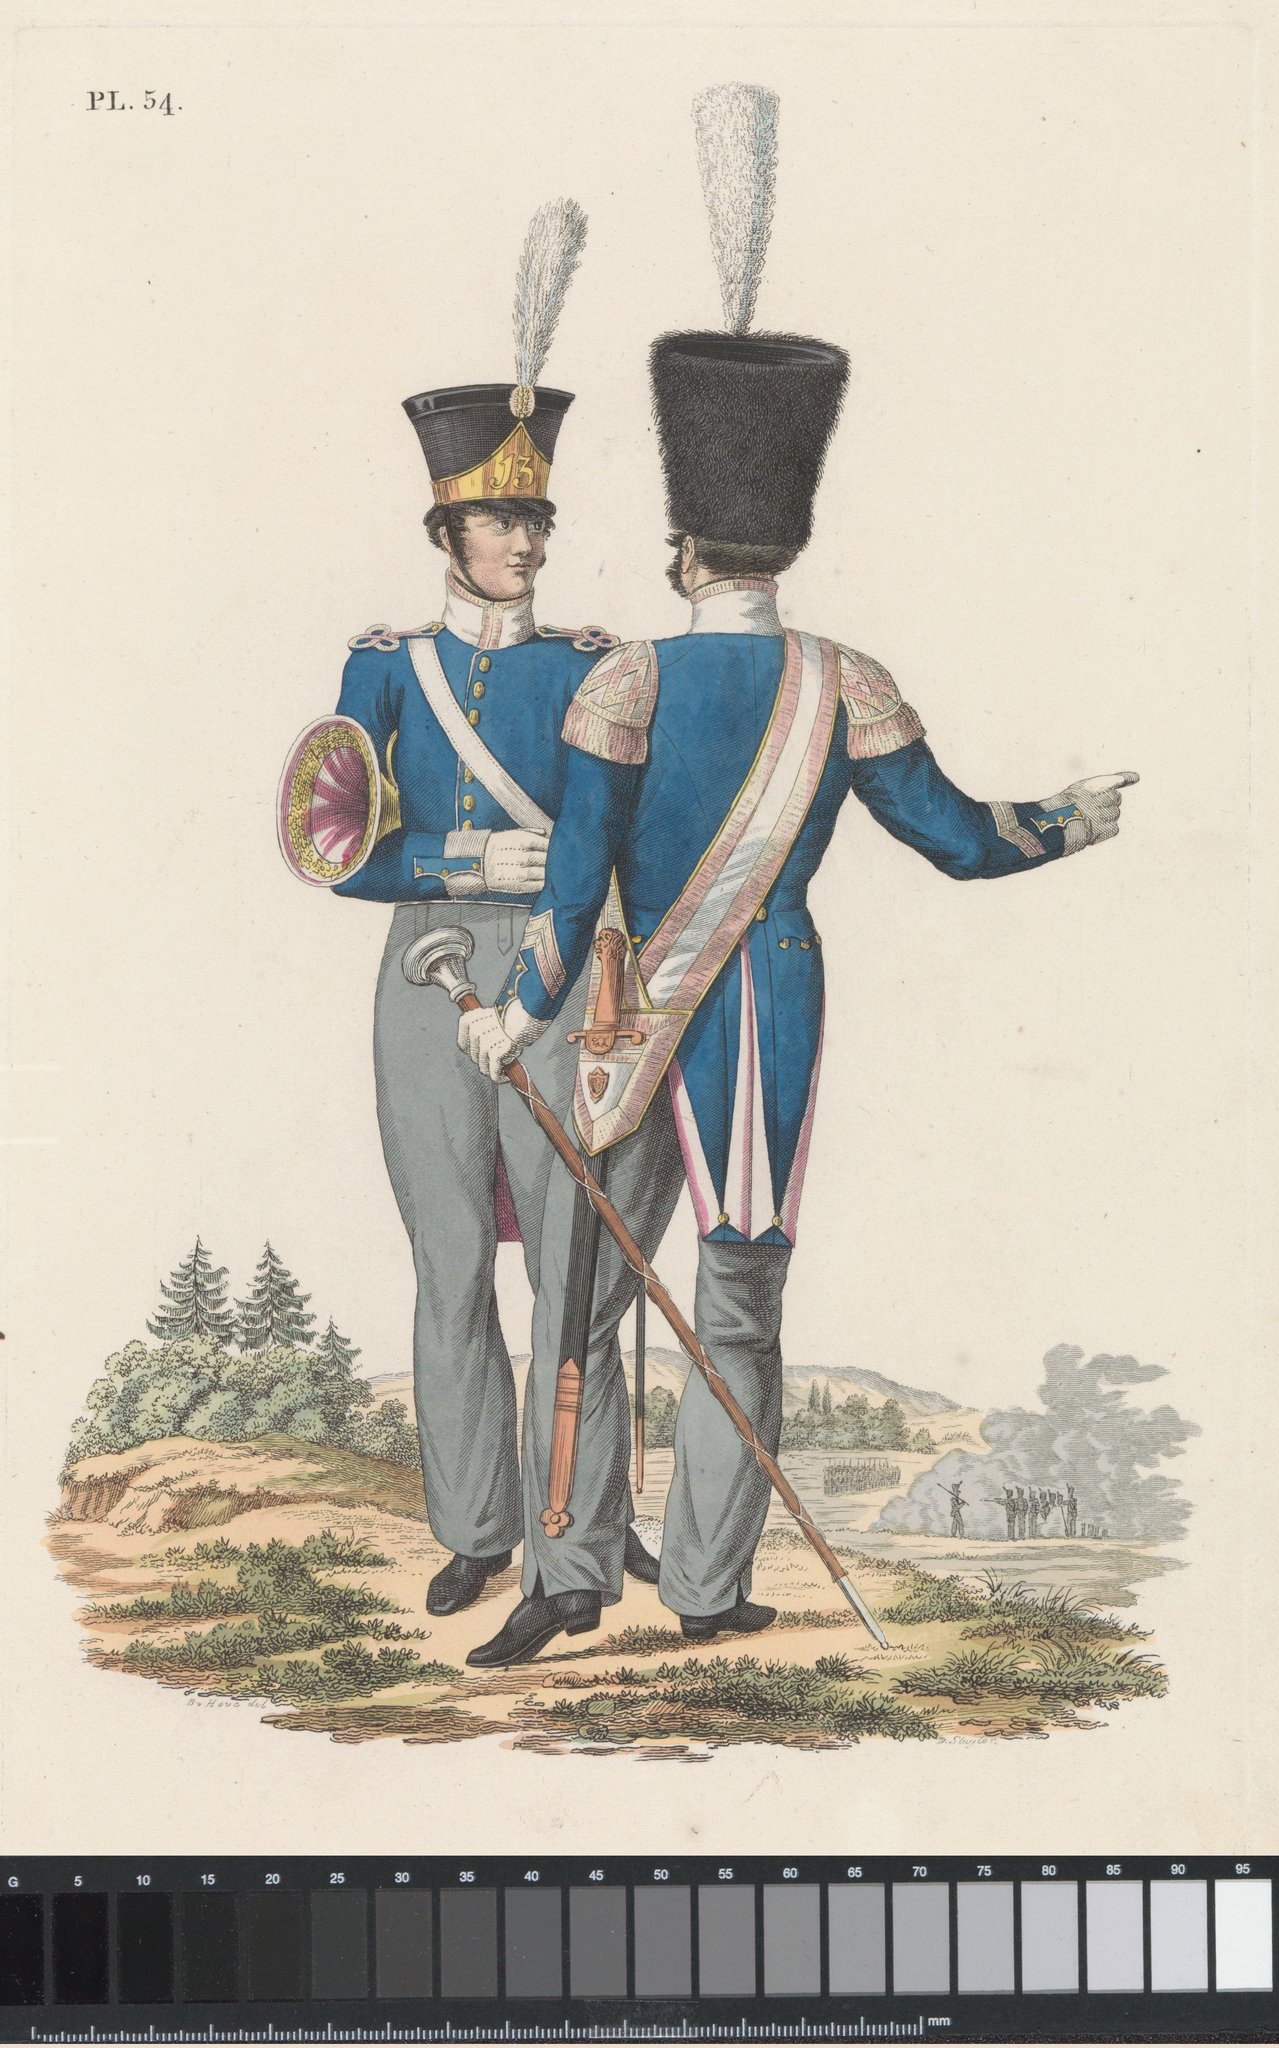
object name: print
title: Tamboer-Majoor, en Muzijkant, beide der Nationale Infanterie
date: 1826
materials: paper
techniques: engraving, etching, hand coloring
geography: netherlands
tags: (military) uniforms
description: Een Nederlandse tamboer-majoor en een muzikant met een hoorn, van een muziekkorps van de 13e Afdeling Infanterie. Plaat 54. Uniformvoorstelling in 'Vervolg van de Beschrijving hoedanig de Koninklijke Nederlandsche troepen' van J.F. Teupken, 1826.